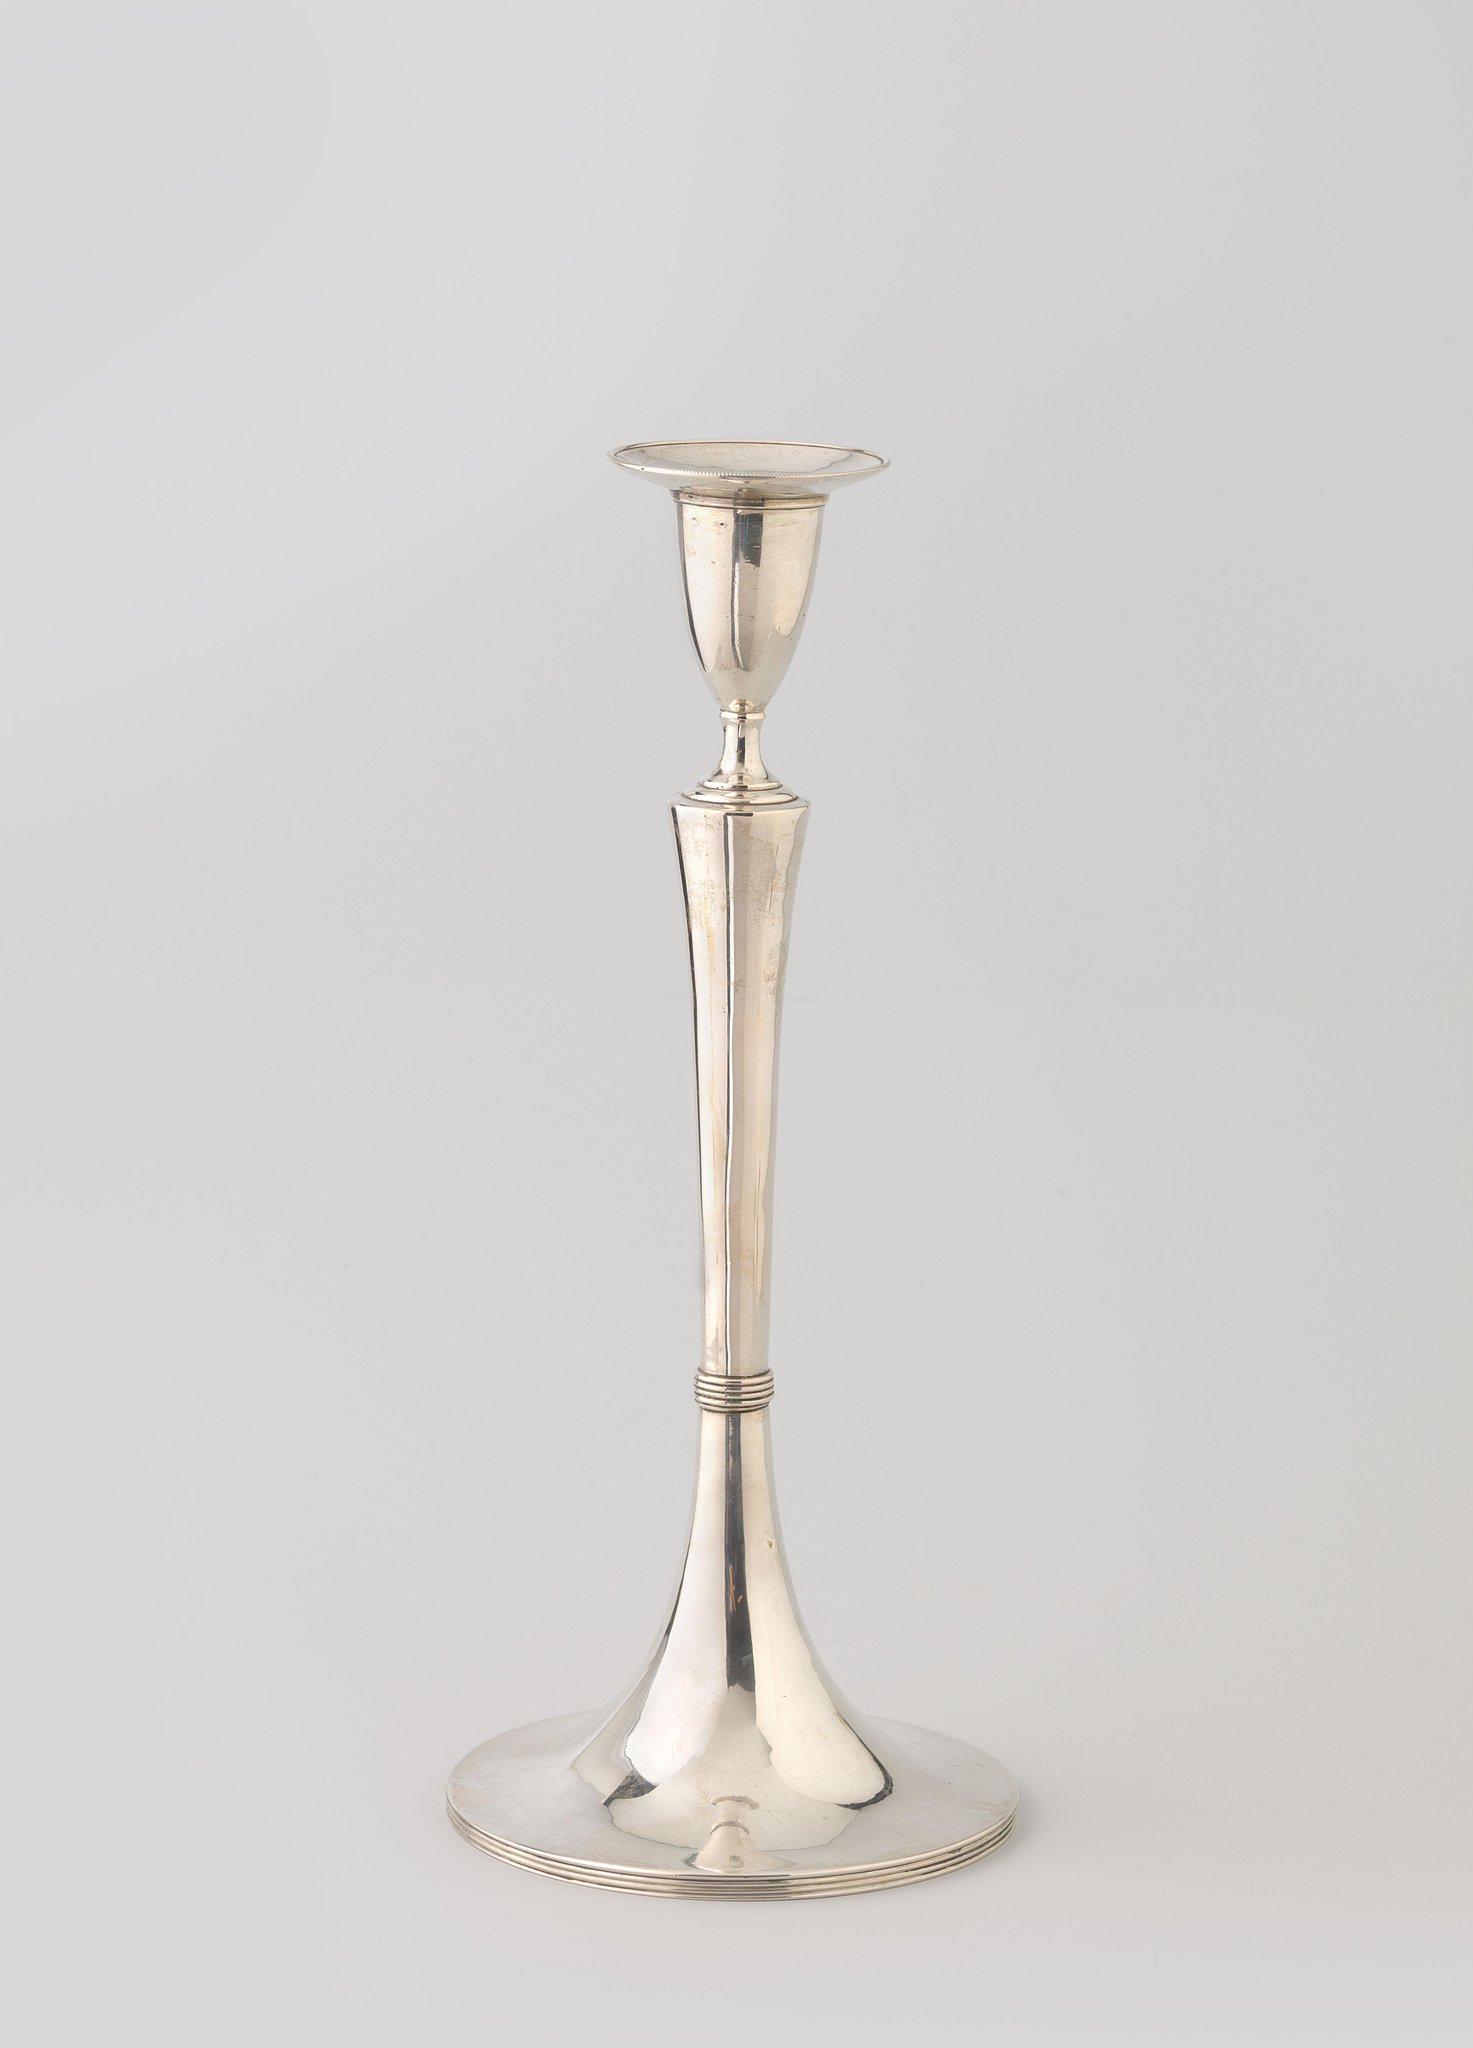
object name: candlestick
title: Kandelaar van zilver op trompetvormige voet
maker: Anonymous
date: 1814-1819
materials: silver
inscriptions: mark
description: Four candlesticks. Silver. Vienna, 1815. Mrs J.E.F.E. de Kleyn-von Artner bequest, 1965.